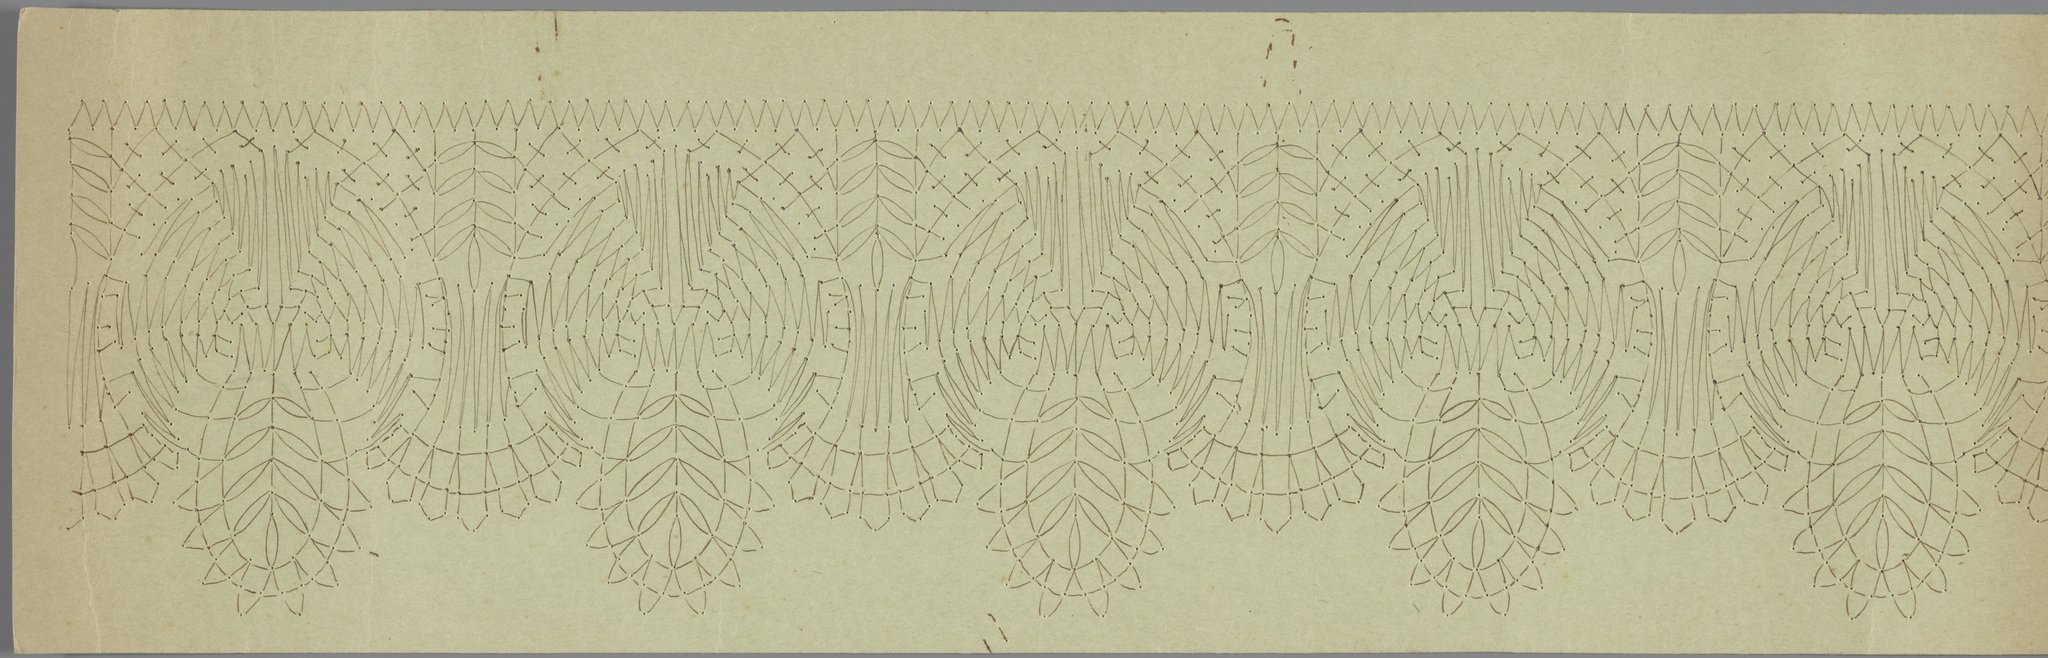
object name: tool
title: Kantpatroon of kantklospatroon van het randmotief van een theetafelkleed (BK-1979-42-A) doorgeprikt op groen karton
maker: l. middendorp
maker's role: designer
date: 1925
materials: cardboard, ink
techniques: drawing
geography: netherlands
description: Kantbrief of kantklospatroon van een motief van een theetafelkleed (BK-1979-42-A). Op een lichtgroen karton is het randmotief, van vijf bloemen, getekend en doorgeprikt.